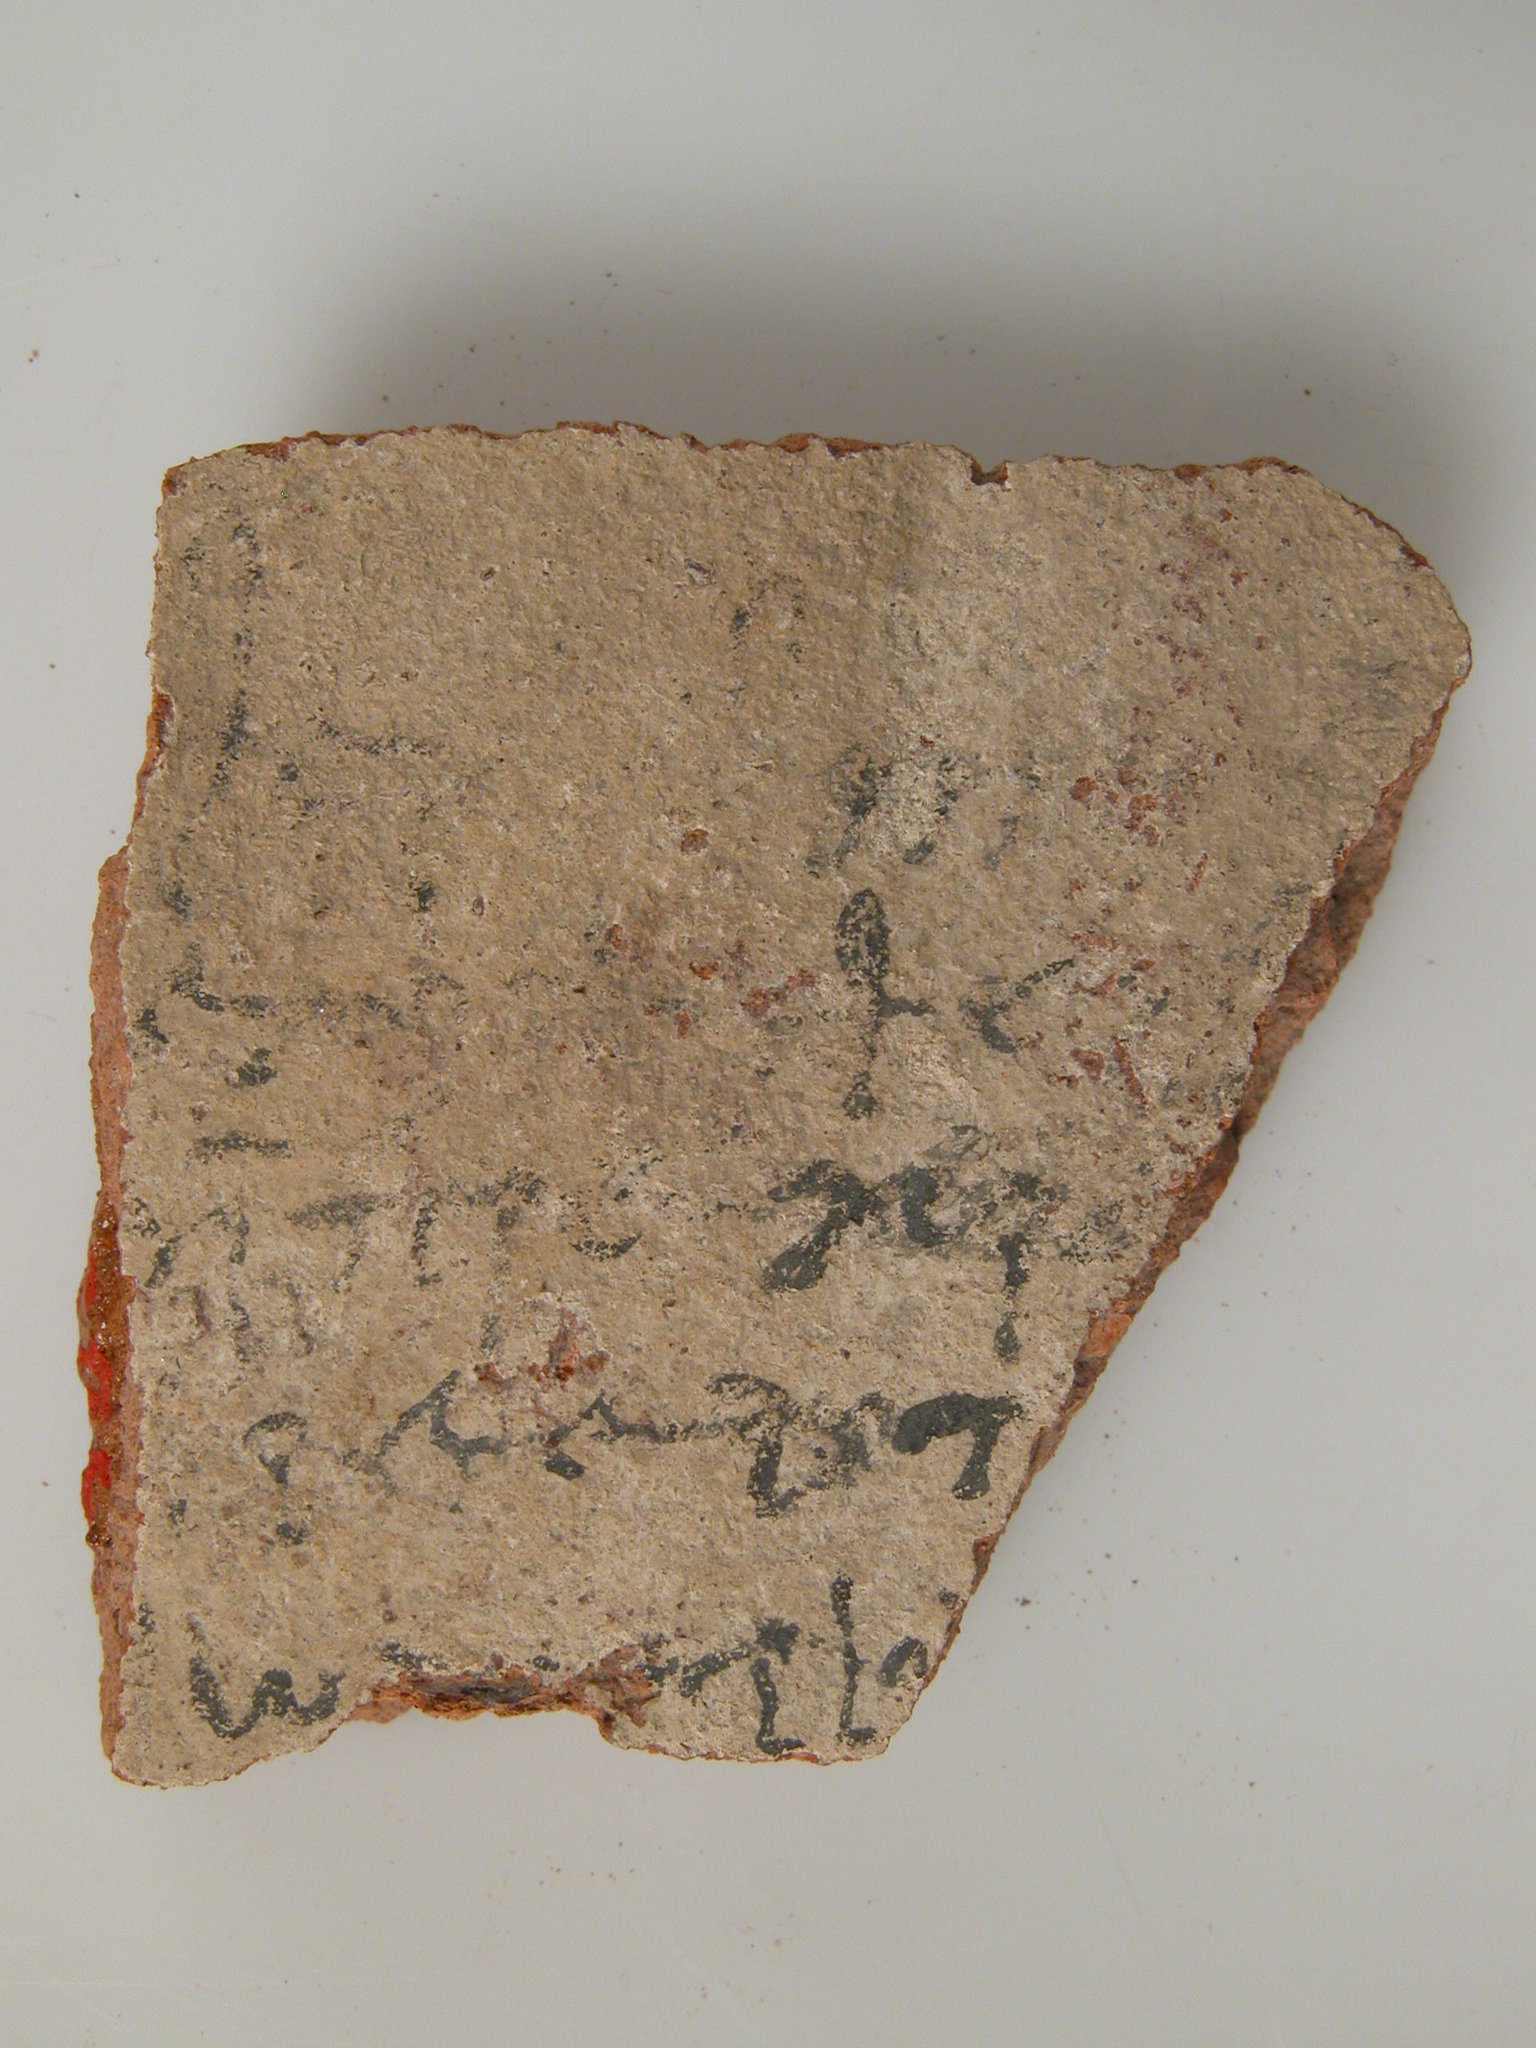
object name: ostrakon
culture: coptic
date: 301-700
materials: ink, pottery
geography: egypt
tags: documents